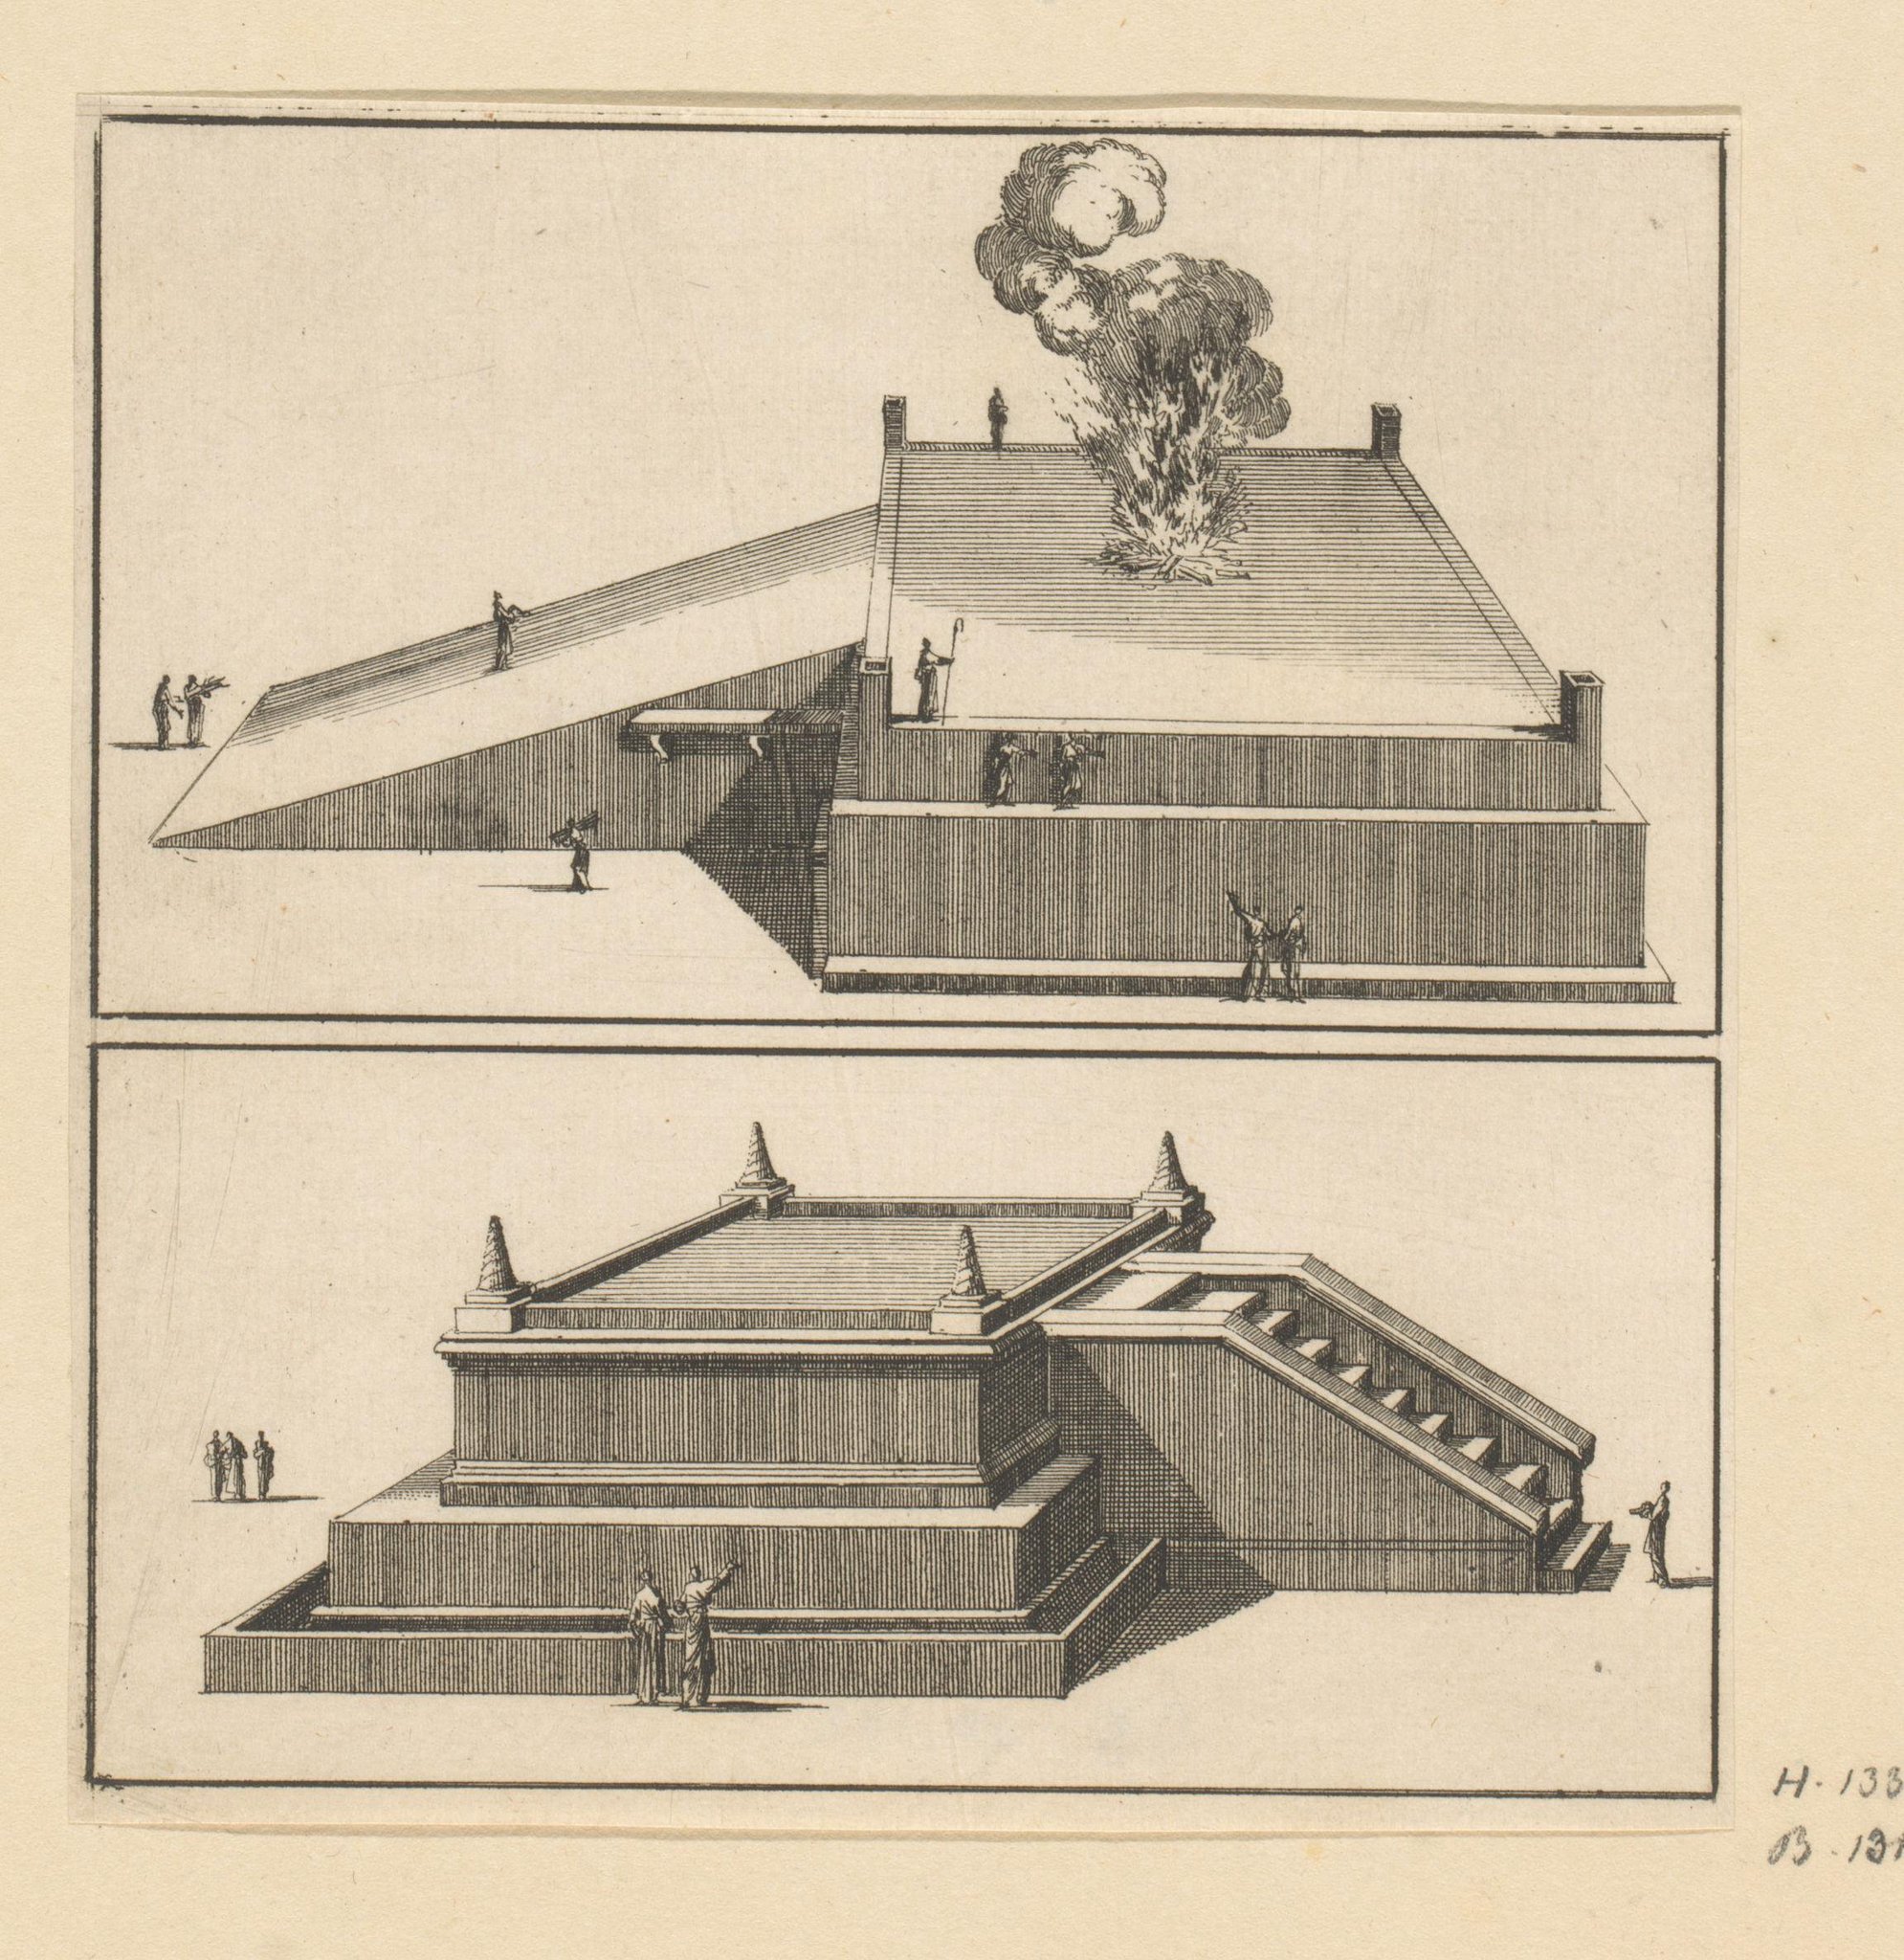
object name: print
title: Altaar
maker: jan luyken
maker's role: draughtsman, print maker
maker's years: 1649-1712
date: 1659-1712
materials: paper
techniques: etching